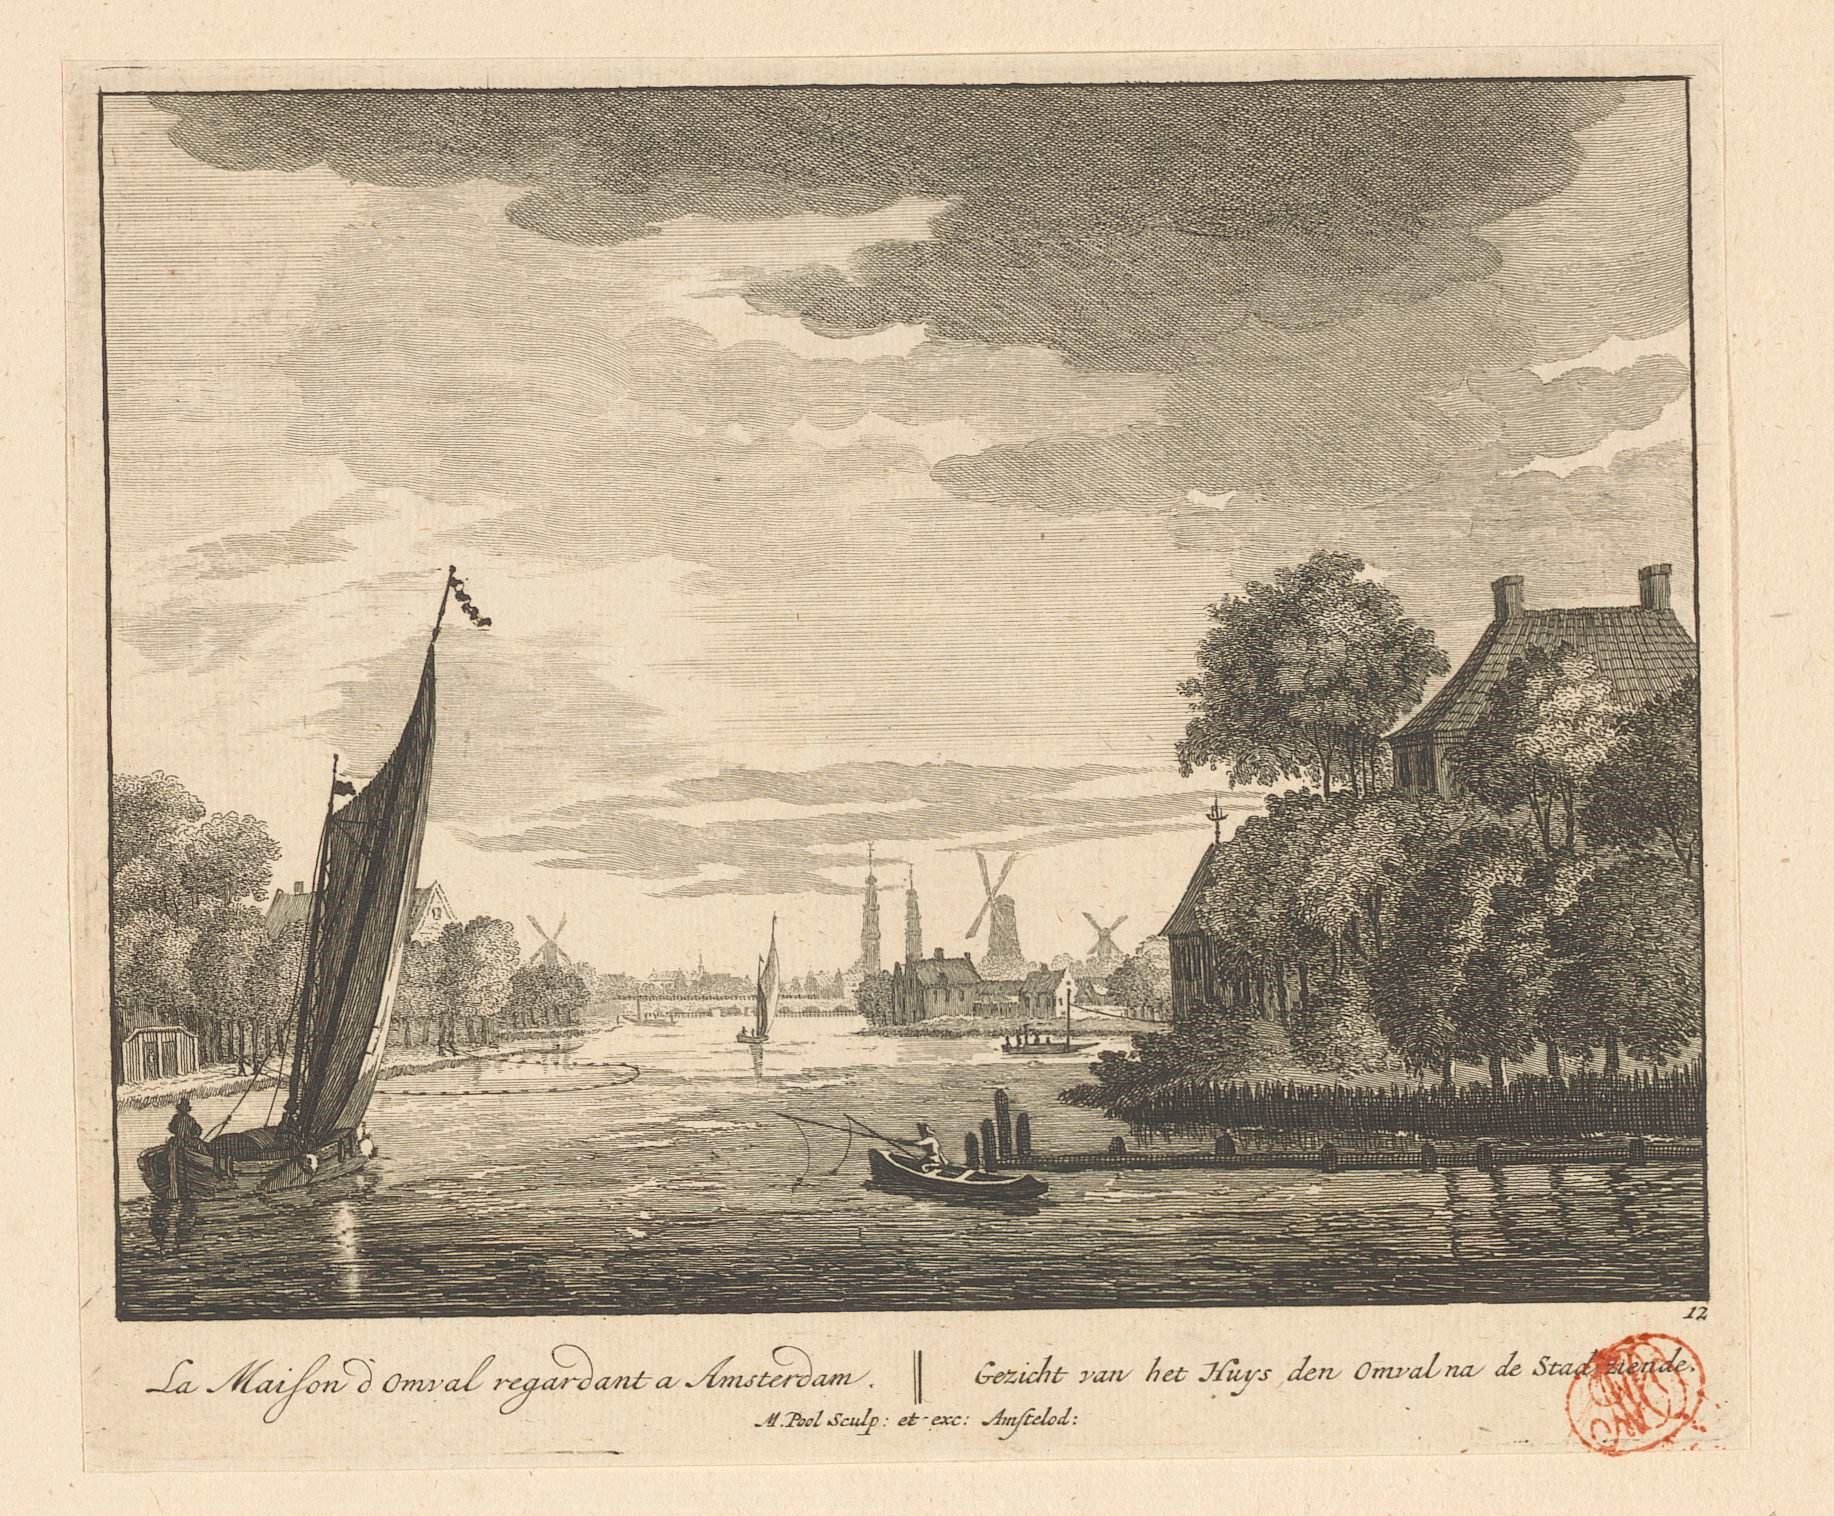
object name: print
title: Gezicht op de Amstel bij Huis De Omval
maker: matthijs pool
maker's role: print maker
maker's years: 1676-1740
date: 1708-1740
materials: paper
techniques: engraving, etching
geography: amsterdam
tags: sailing-ship, sailing-boat, river, rowing-boat, canoe, etc.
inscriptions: collector's mark: Lugt 2233, collector's mark: Lugt 195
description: Prent gebruikt in: Pool, Matthijs. Verscheyde gesigten van de vermaarde rievier de buyten Amstel van de stadt Amsterdam, tot het dorp Ouwerkerk (…) / Plusieurs veuës et perspectives de la fameuse riviére de Buyten-Amstel depuis Amsterdam jusqu'au village d'Ouwerkerk (…). Amsterdam: Matthijs Pool, z.j. [1708-1740].